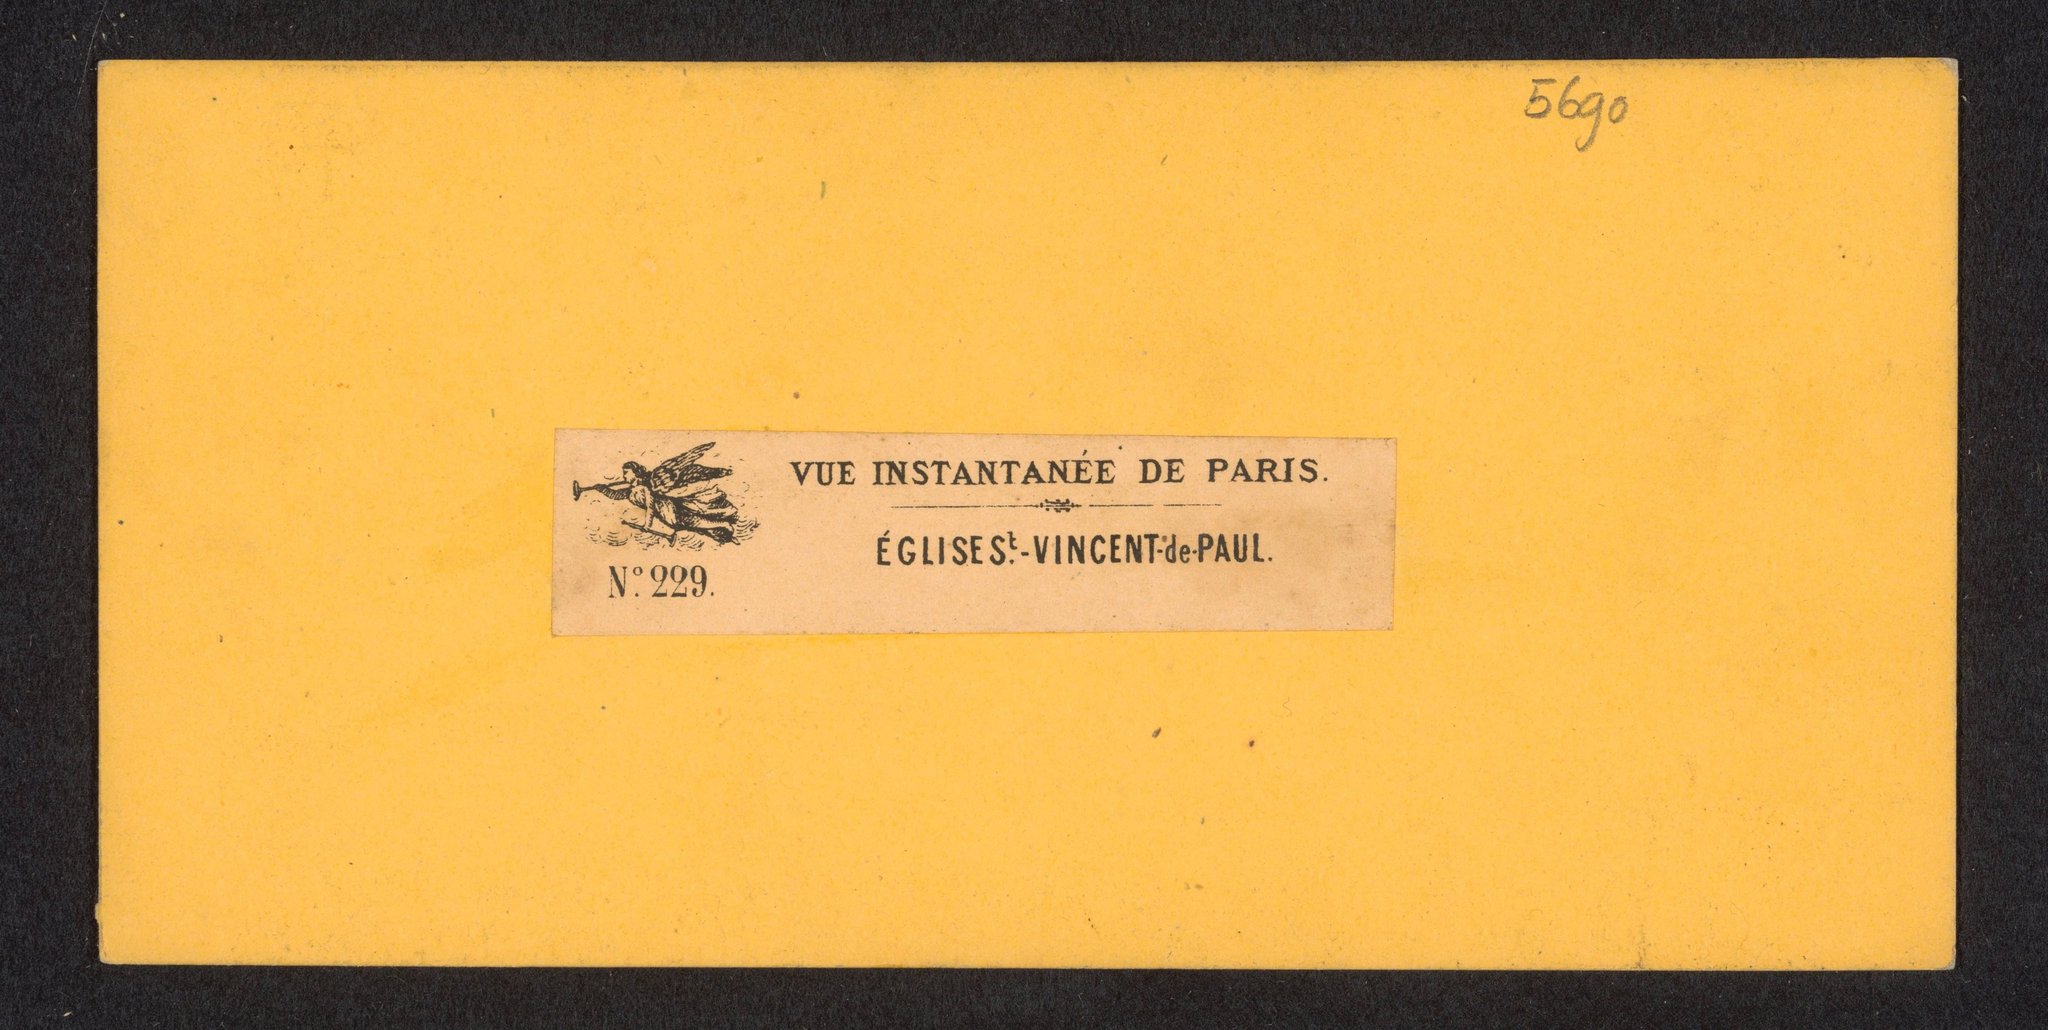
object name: stereograph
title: Gezicht op de Église Saint-Vincent-de-Paul in Parijs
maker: Anonymous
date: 1850-1880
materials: cardboard, photographic support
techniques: albumen print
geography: paris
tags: church (exterior)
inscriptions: number: ‘No. 229.’